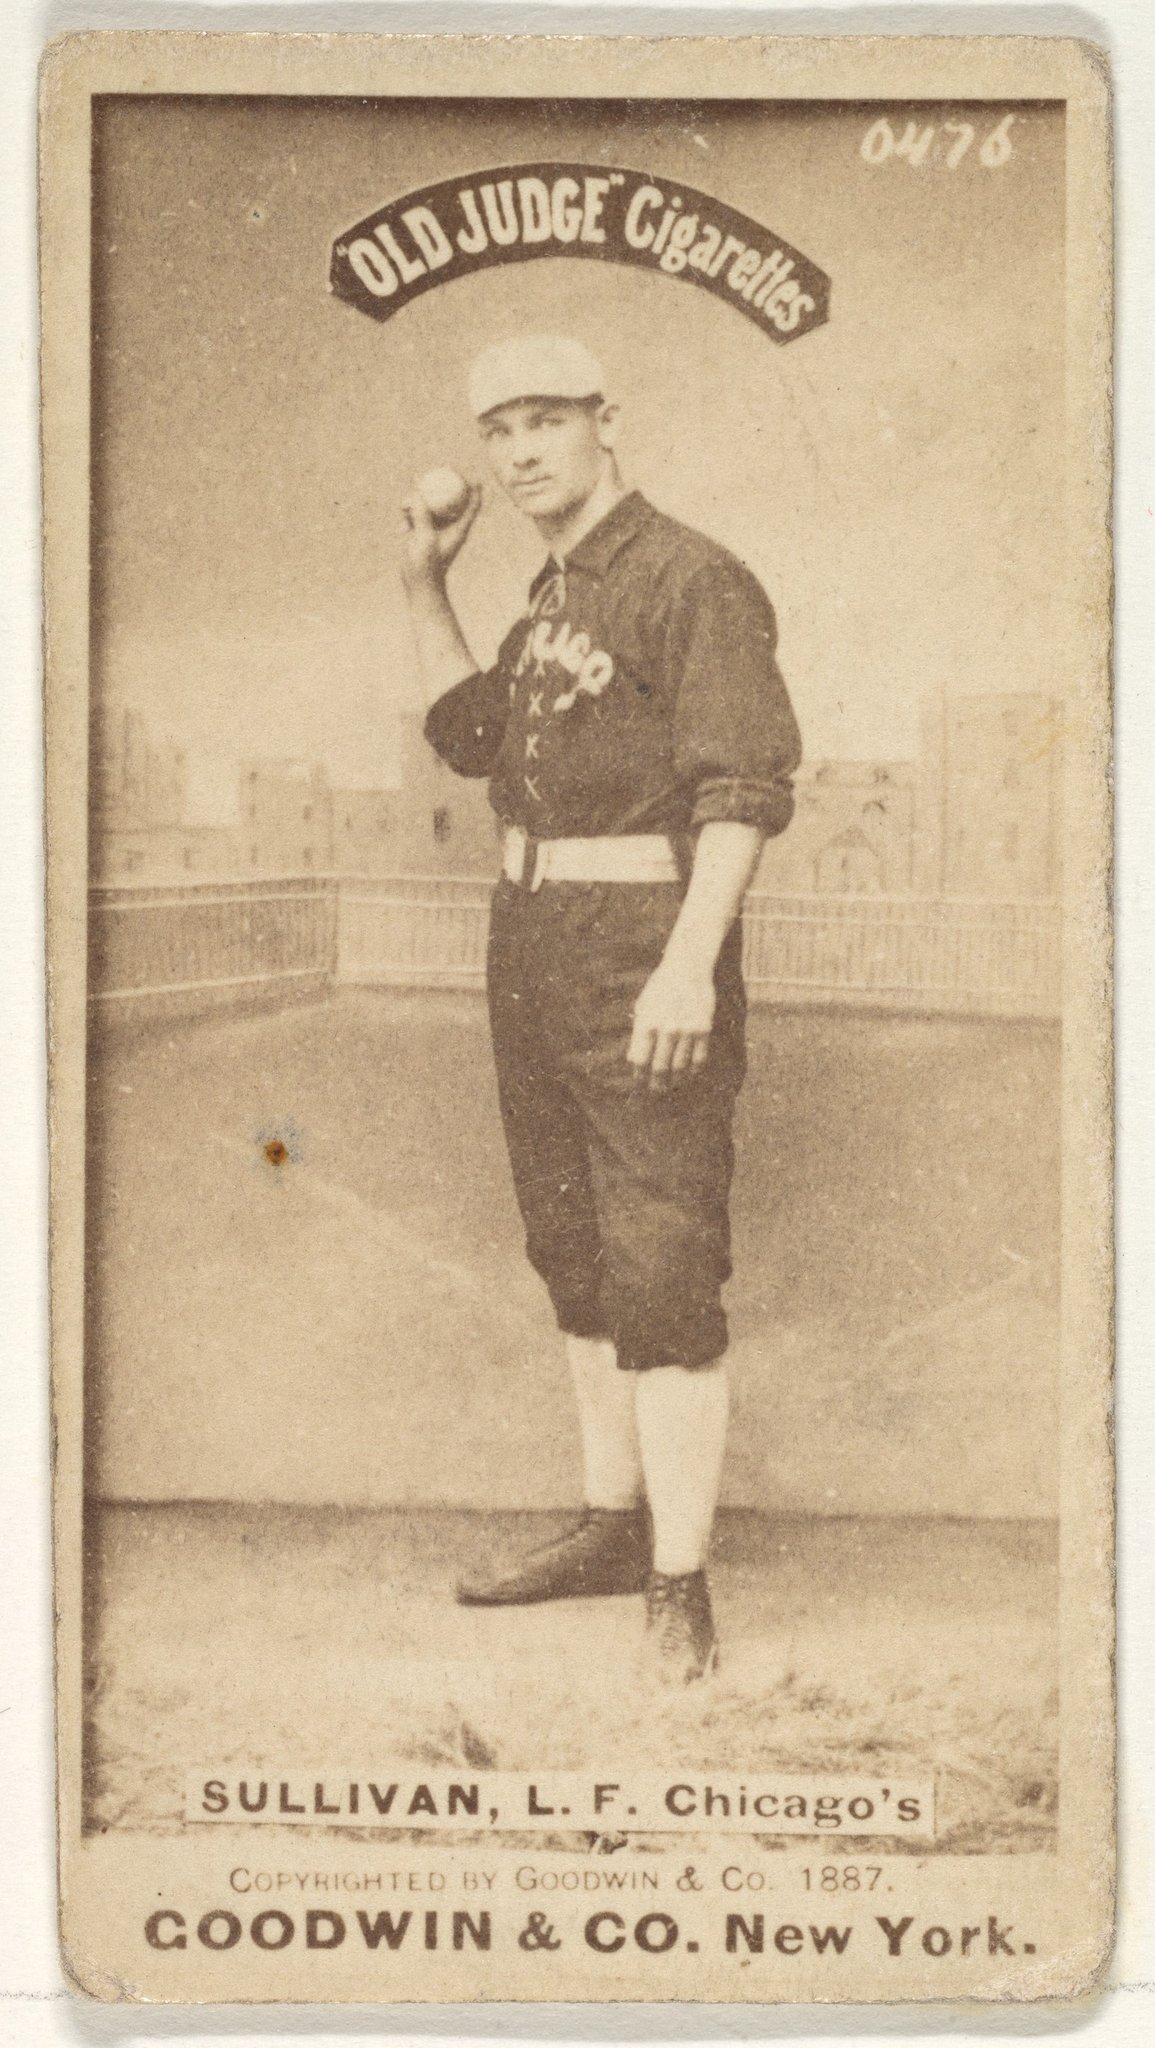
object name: baseball card, photograph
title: Sullivan, Left Field, Chicago, from the Old Judge series (N172) for Old Judge Cigarettes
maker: goodwin & company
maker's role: publisher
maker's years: 1850-1950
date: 1887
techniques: albumen silver print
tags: men,portraits,baseball,athletes